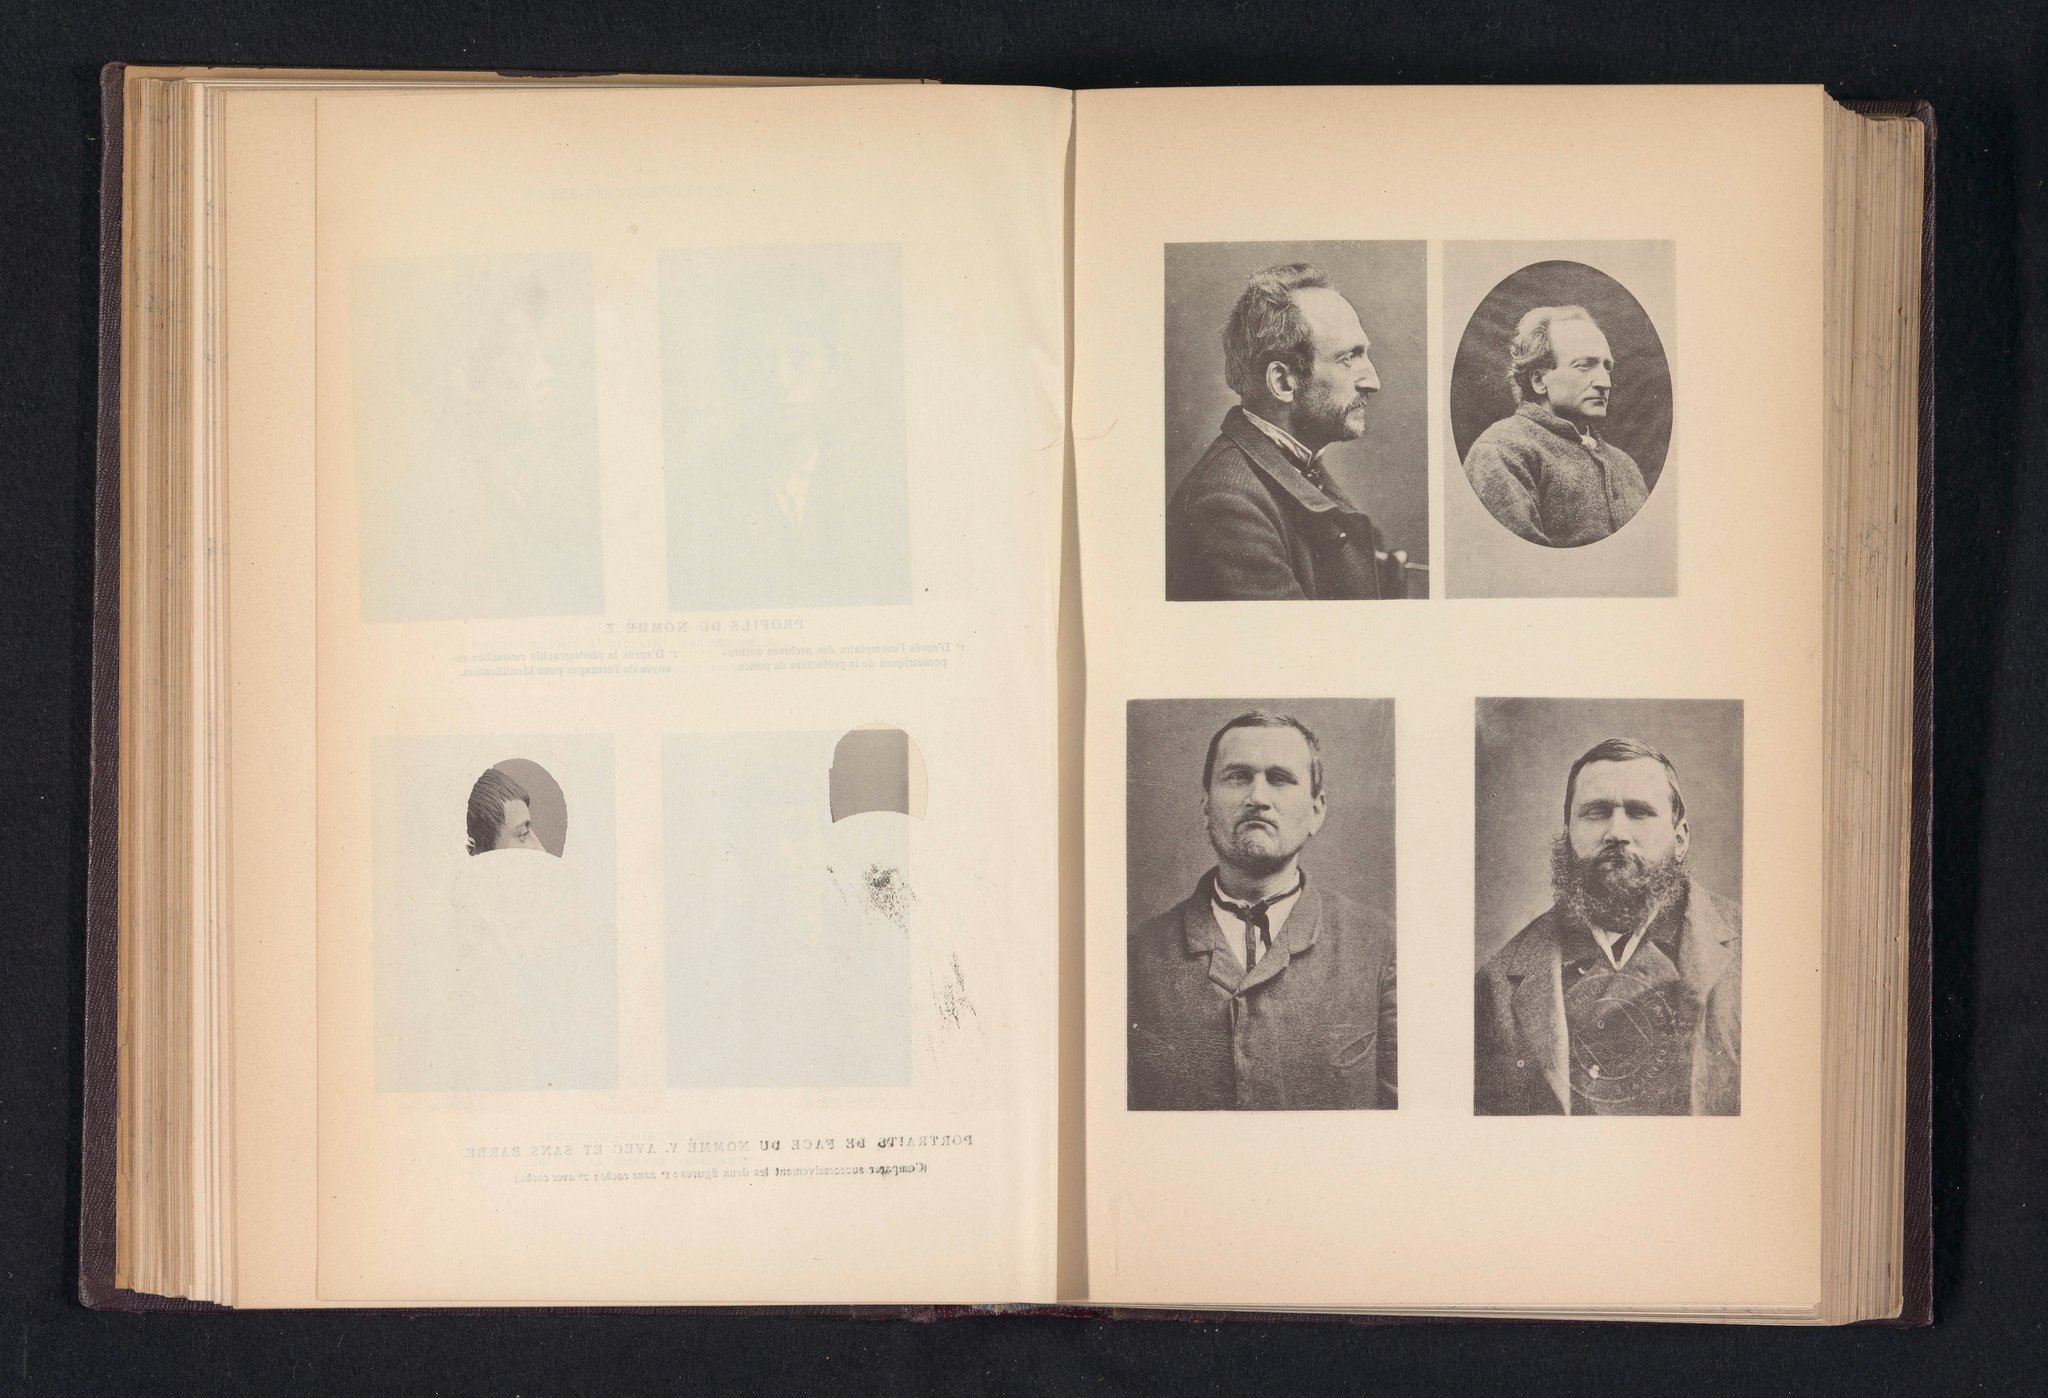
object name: photomechanical print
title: Vier portretten van twee criminelen, met en zonder baard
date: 1881-1891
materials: paper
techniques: photograph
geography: paris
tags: criminals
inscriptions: inscription: ‘Profils du Nommé Z. (...) Portraits de face Nommé Y. avec et sans babre. (...)’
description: Uit het schutblad zijn twee kaders gesneden om een deel van de onderste portretten te zien.